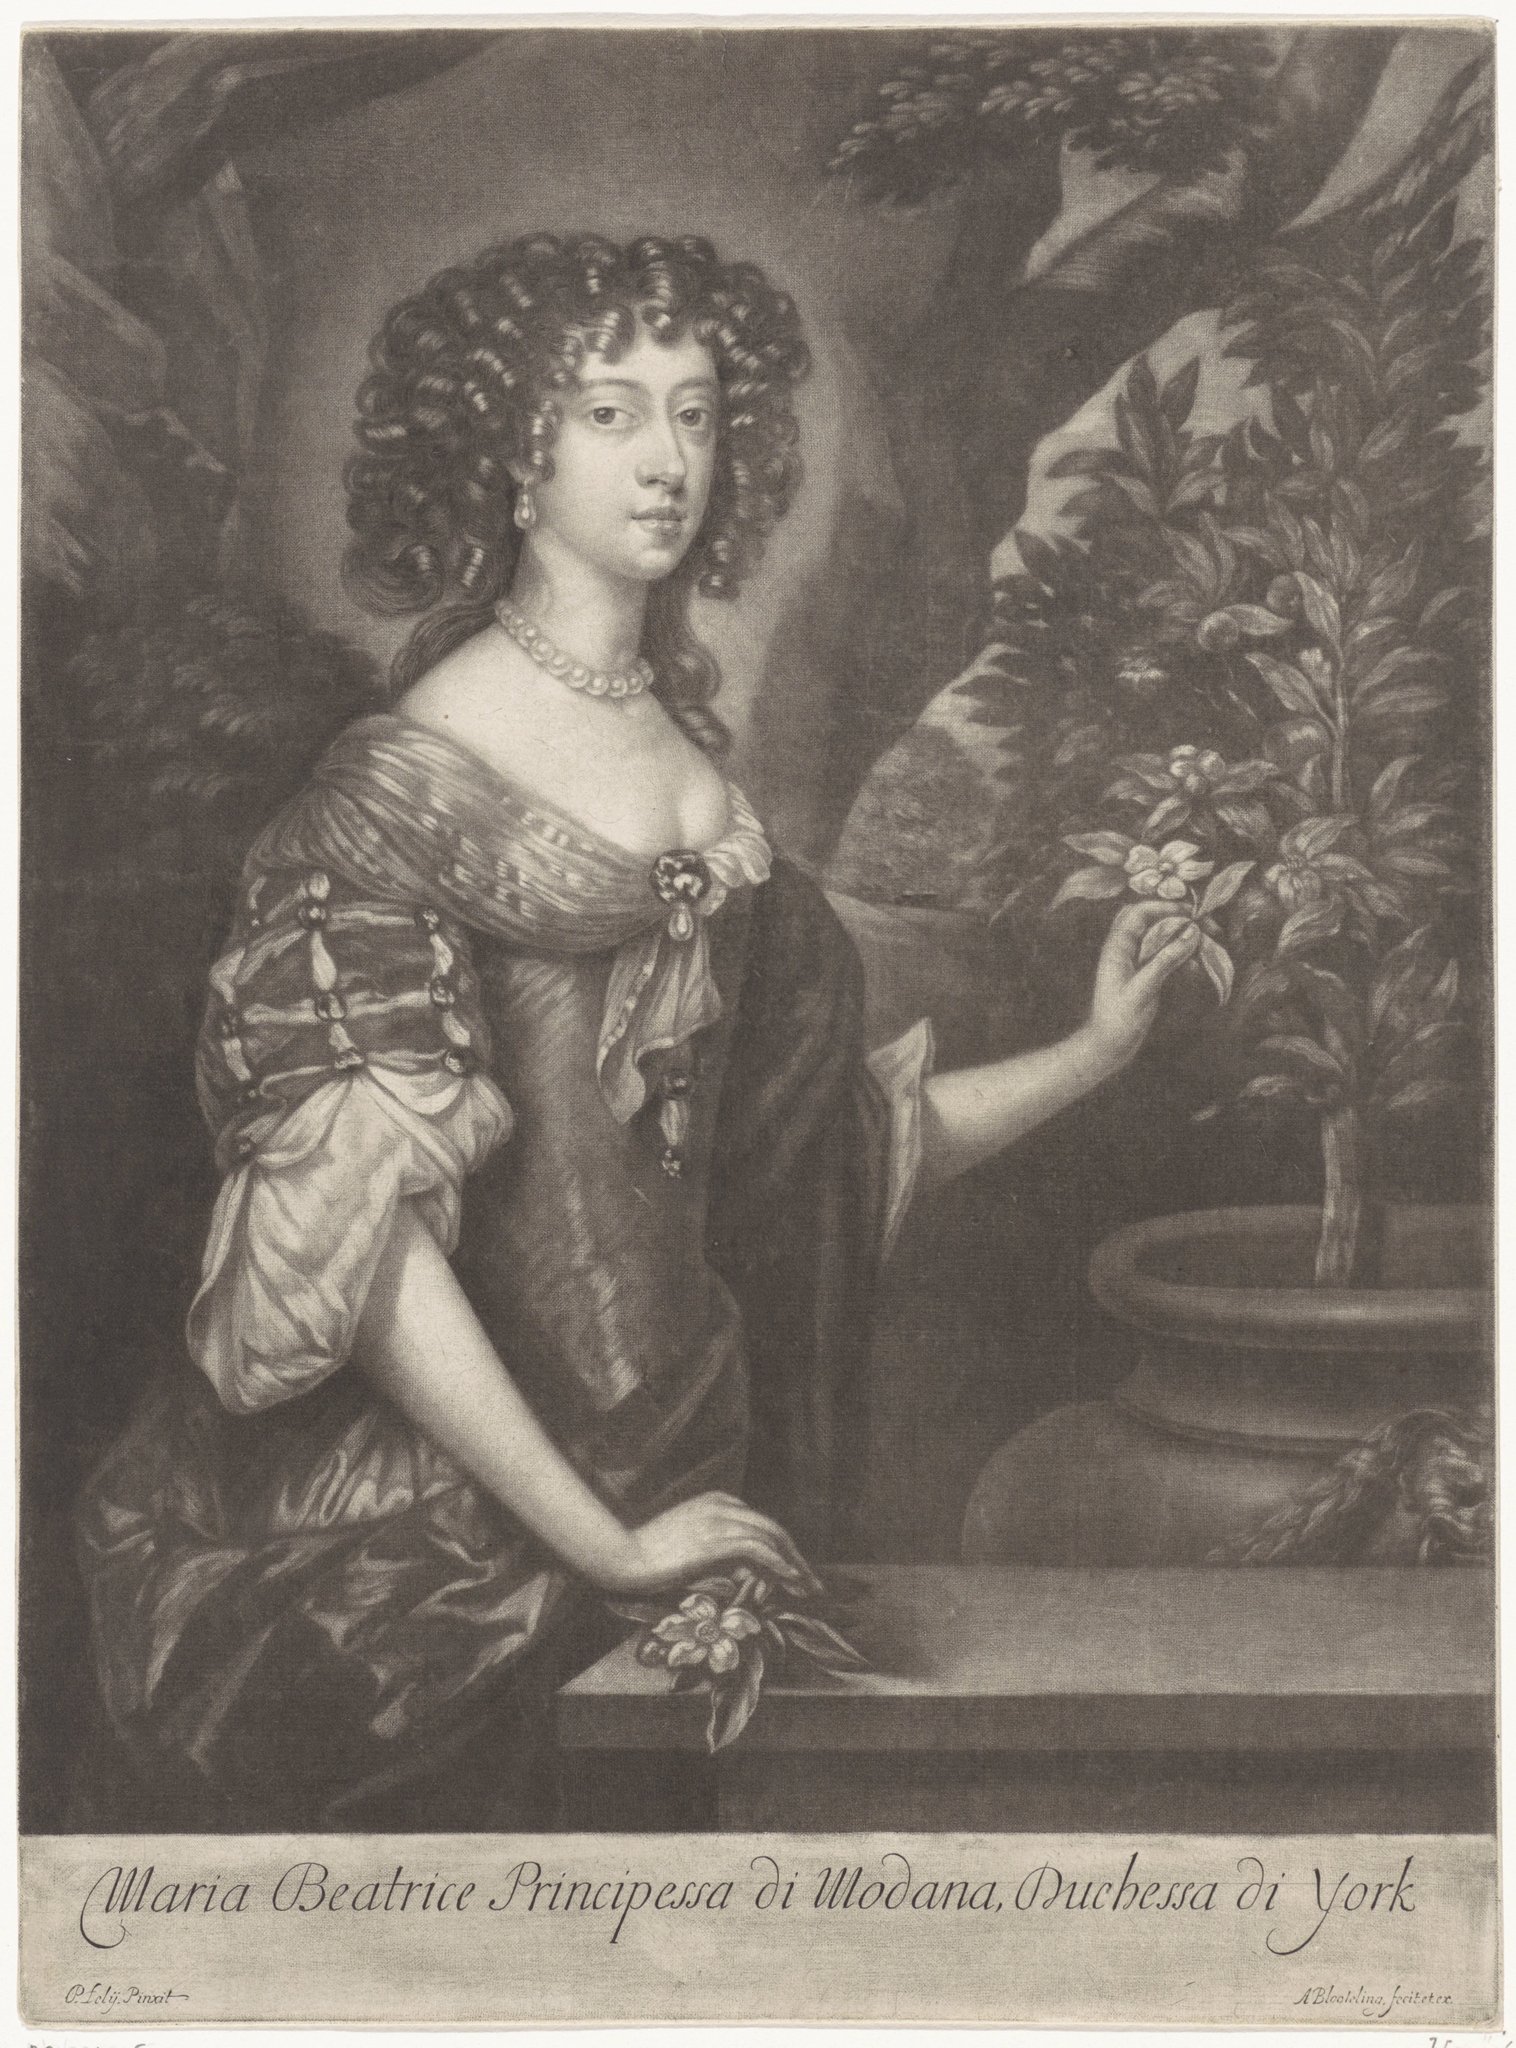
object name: print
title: Portret van Maria Beatrice van Modena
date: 1673-1690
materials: paper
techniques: engraving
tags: paris, flowers, garden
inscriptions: collector's mark: Lugt 2228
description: Maria Beatrice Eleanor Anne Margaret Isabella d’Este, dochter van Alfonso d’Este III, hertog van Modena. Ze was vanaf 1685 tot 1689 koningin van Engeland.